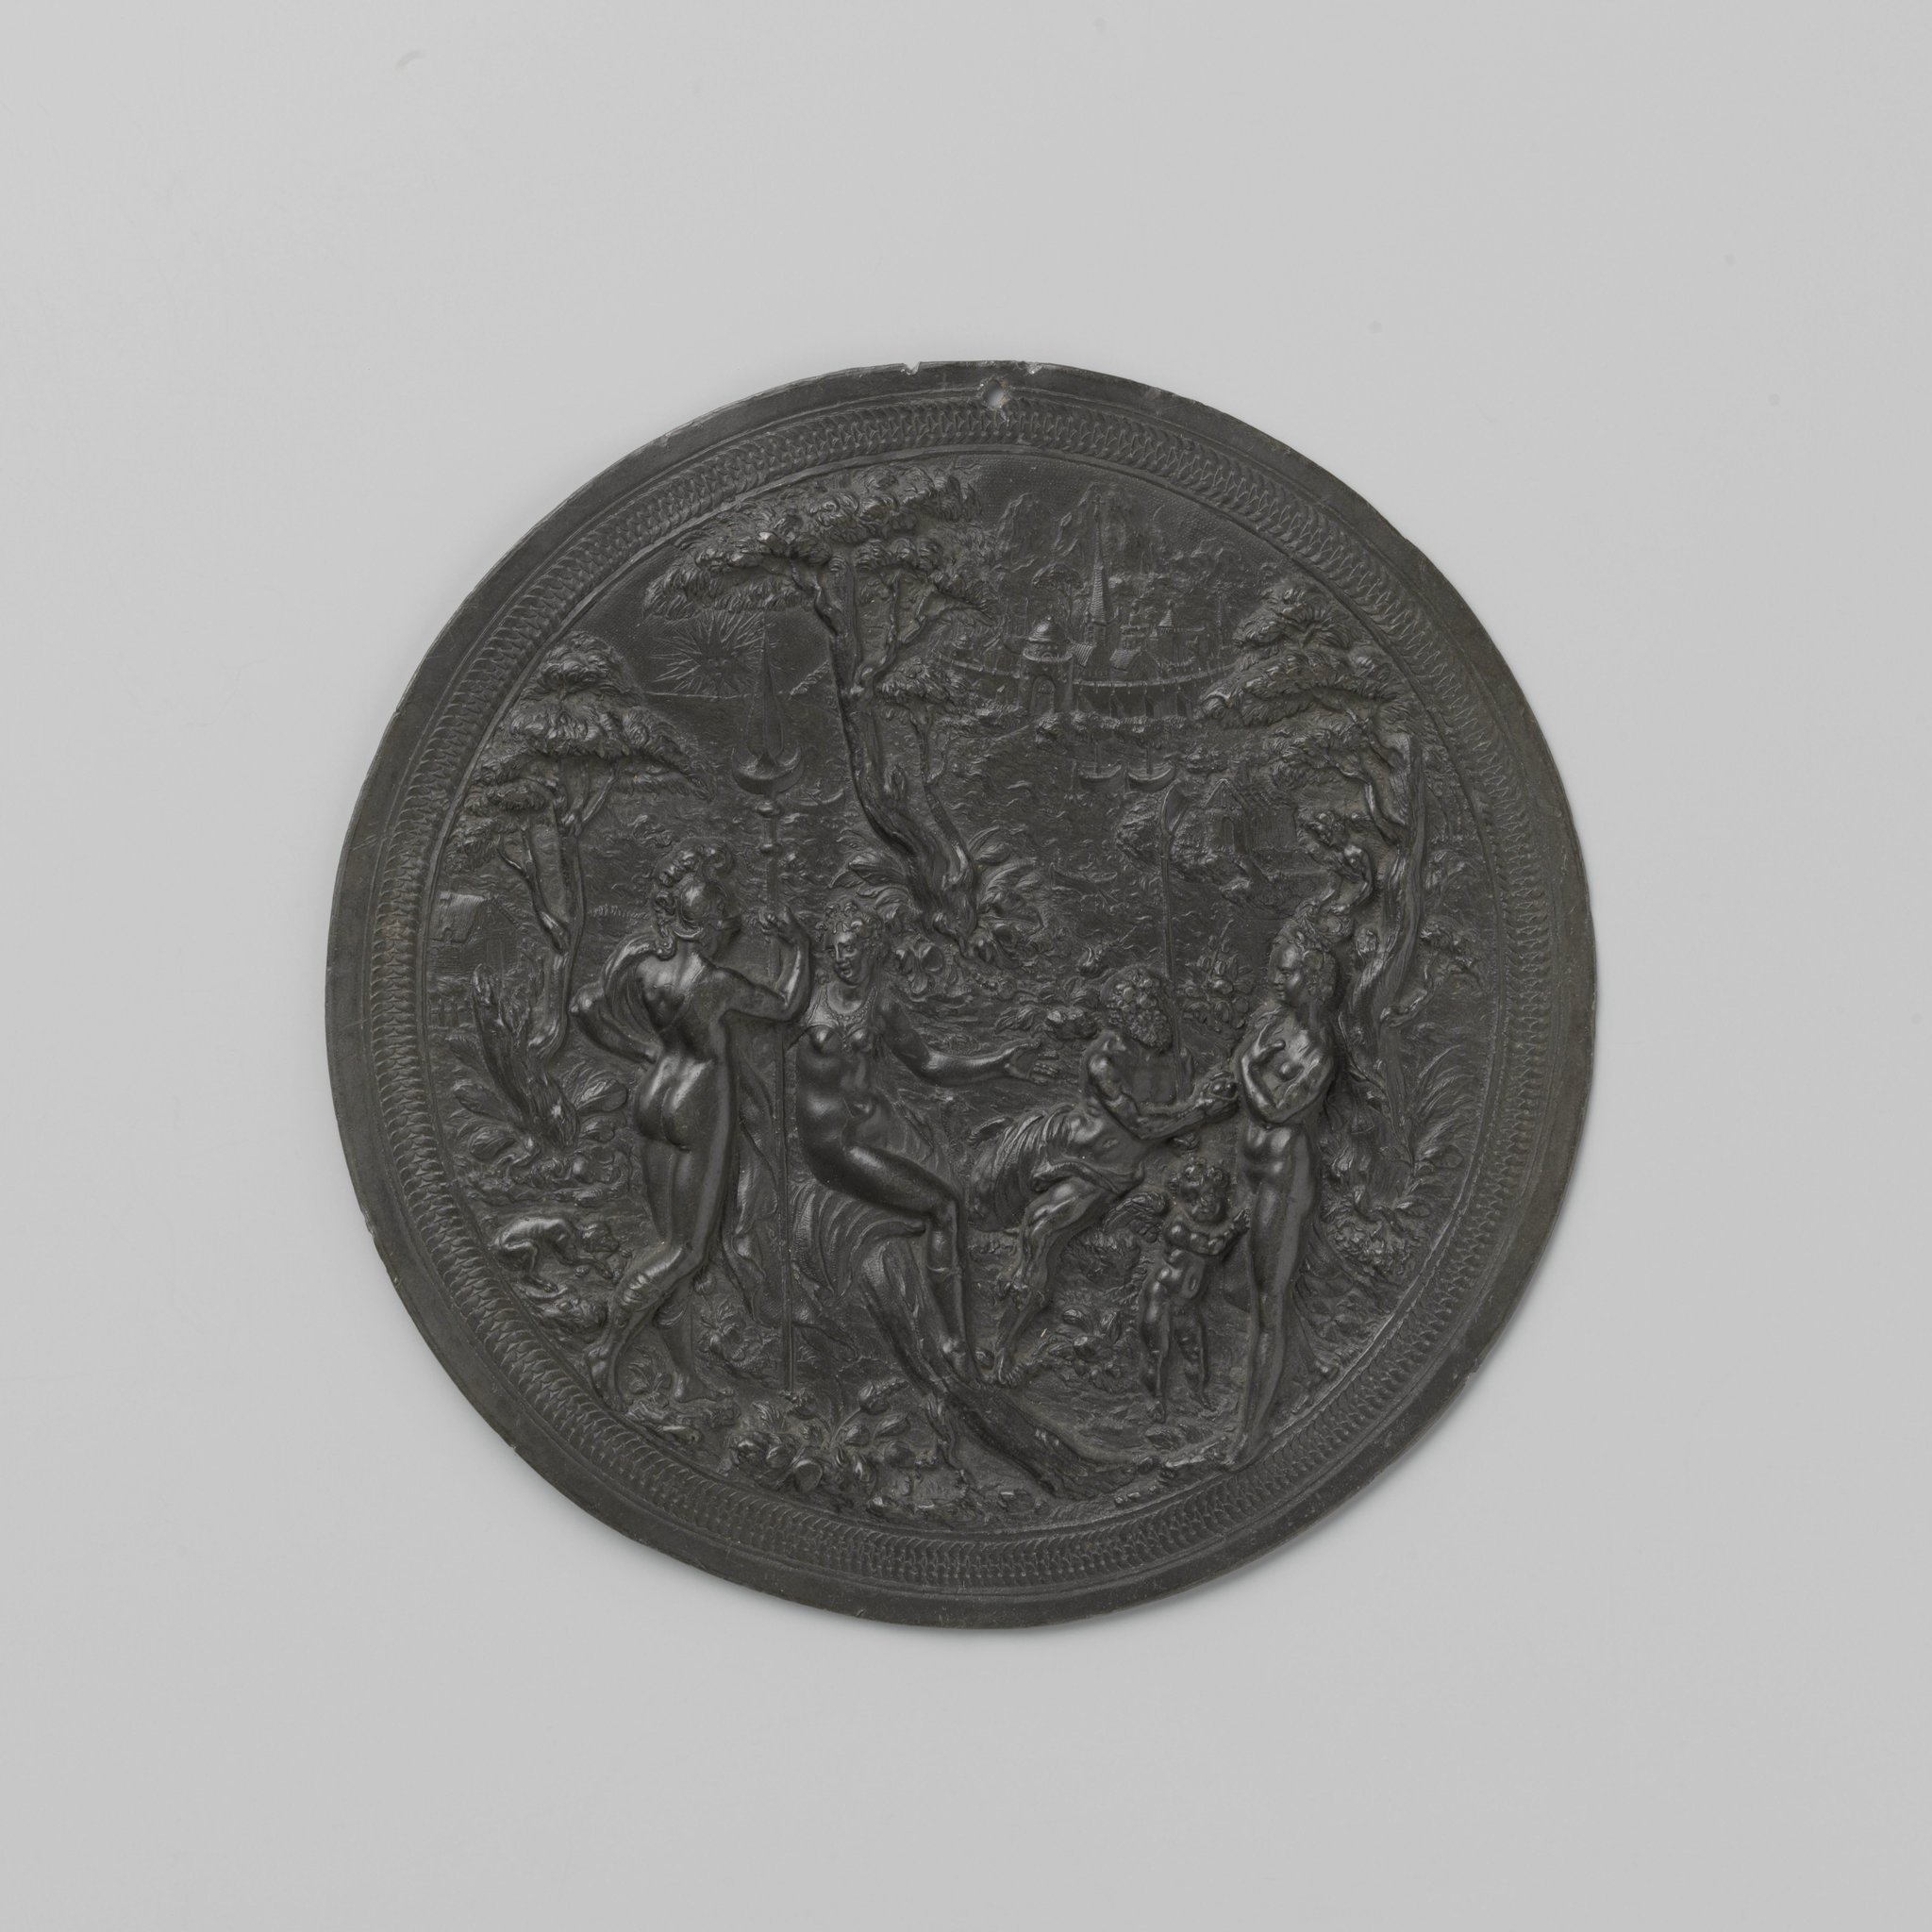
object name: plaque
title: Het oordeel van Paris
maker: hans jamnitzer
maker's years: 1539-1603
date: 1550-1575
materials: lead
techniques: casting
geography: nuremberg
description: Ronde, loden plaquette, omgeven door een vlechtband. Rechts Venus met Amor aan haar voeten. Paris reikt haar de Appel met het opschrift "voor de mooiste", wat het voorspel zou worden tot de Trojaanse oorlog. Links Minerva, driekwart van achteren gezien en leunende op de speerin heer rechterhand. Voor haar zit Juno, die naar haar opziet. geheel links een hondje. Achter de figueren, ter weerszijden en in het midden, zware bomen. Boven een breed water aan de horizon het stralend aangezicht der zon. Rechts op de achtergrond schepen, gebouwen en de ommuurde stad Troje voor hoge bergtoppen.